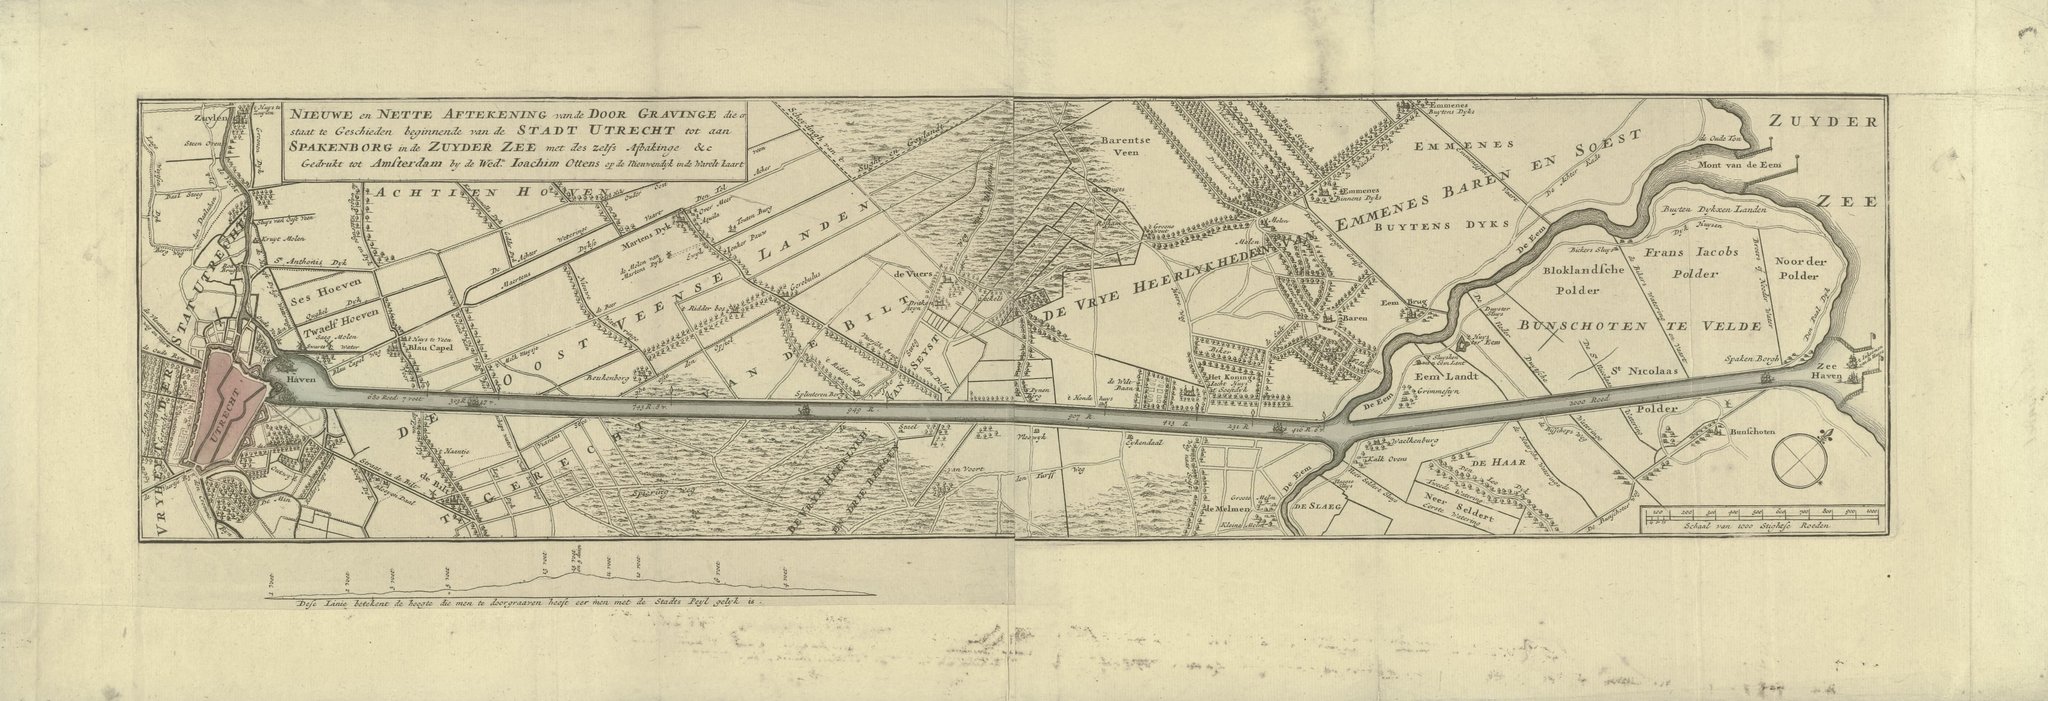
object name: print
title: Het Groote Tafereel der Dwaasheid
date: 1720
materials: paper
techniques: engraving, etching, hand coloring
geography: northern netherlands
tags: financial panic, maps of separate countries or regions, utrecht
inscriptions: collector's mark: Lugt 2228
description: Kaart in twee delen van het voorgestelde kanaal te graven tussen Utrecht en de Zuiderzee. Voor dit project werd in 1720 geld ingezameld. Rechtsonder een schaalstok: Schaal van 1000 Stightse roeden. Prent 6 in de serie Het Groote Tafereel der Dwaasheid met spotprenten op de Windhandel of Actiehandel van 1720.